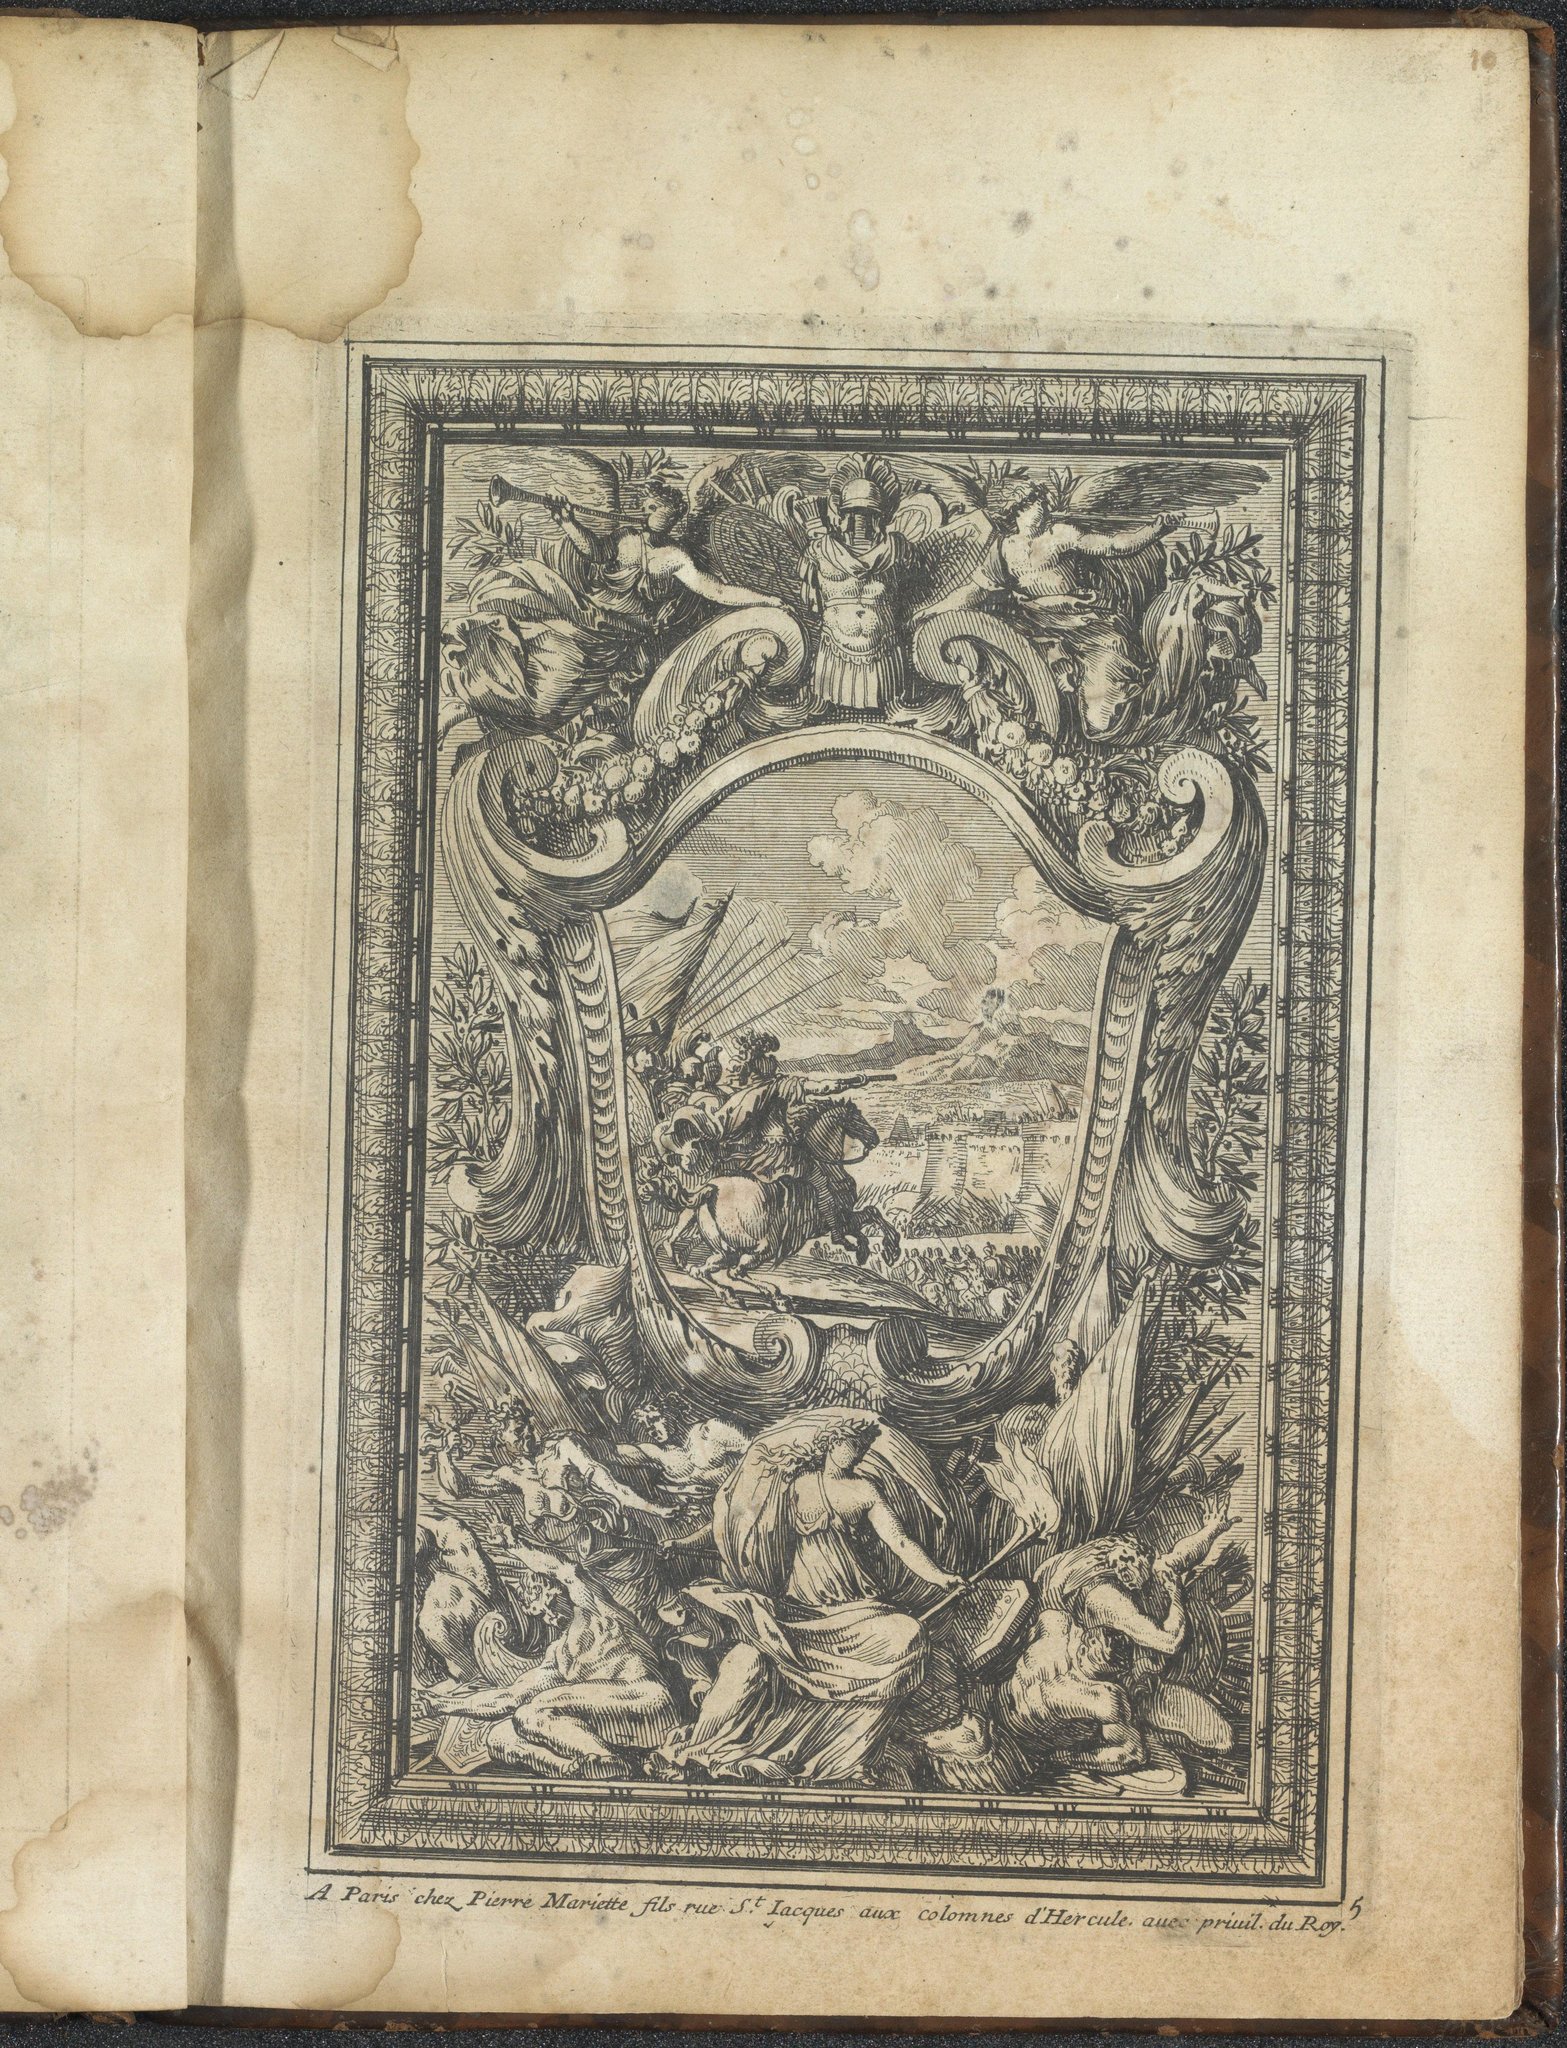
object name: album leaf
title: Paneel met belegering van stad in cartouche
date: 1655-1657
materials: paper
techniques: etching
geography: paris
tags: ornaments ~ art, siege